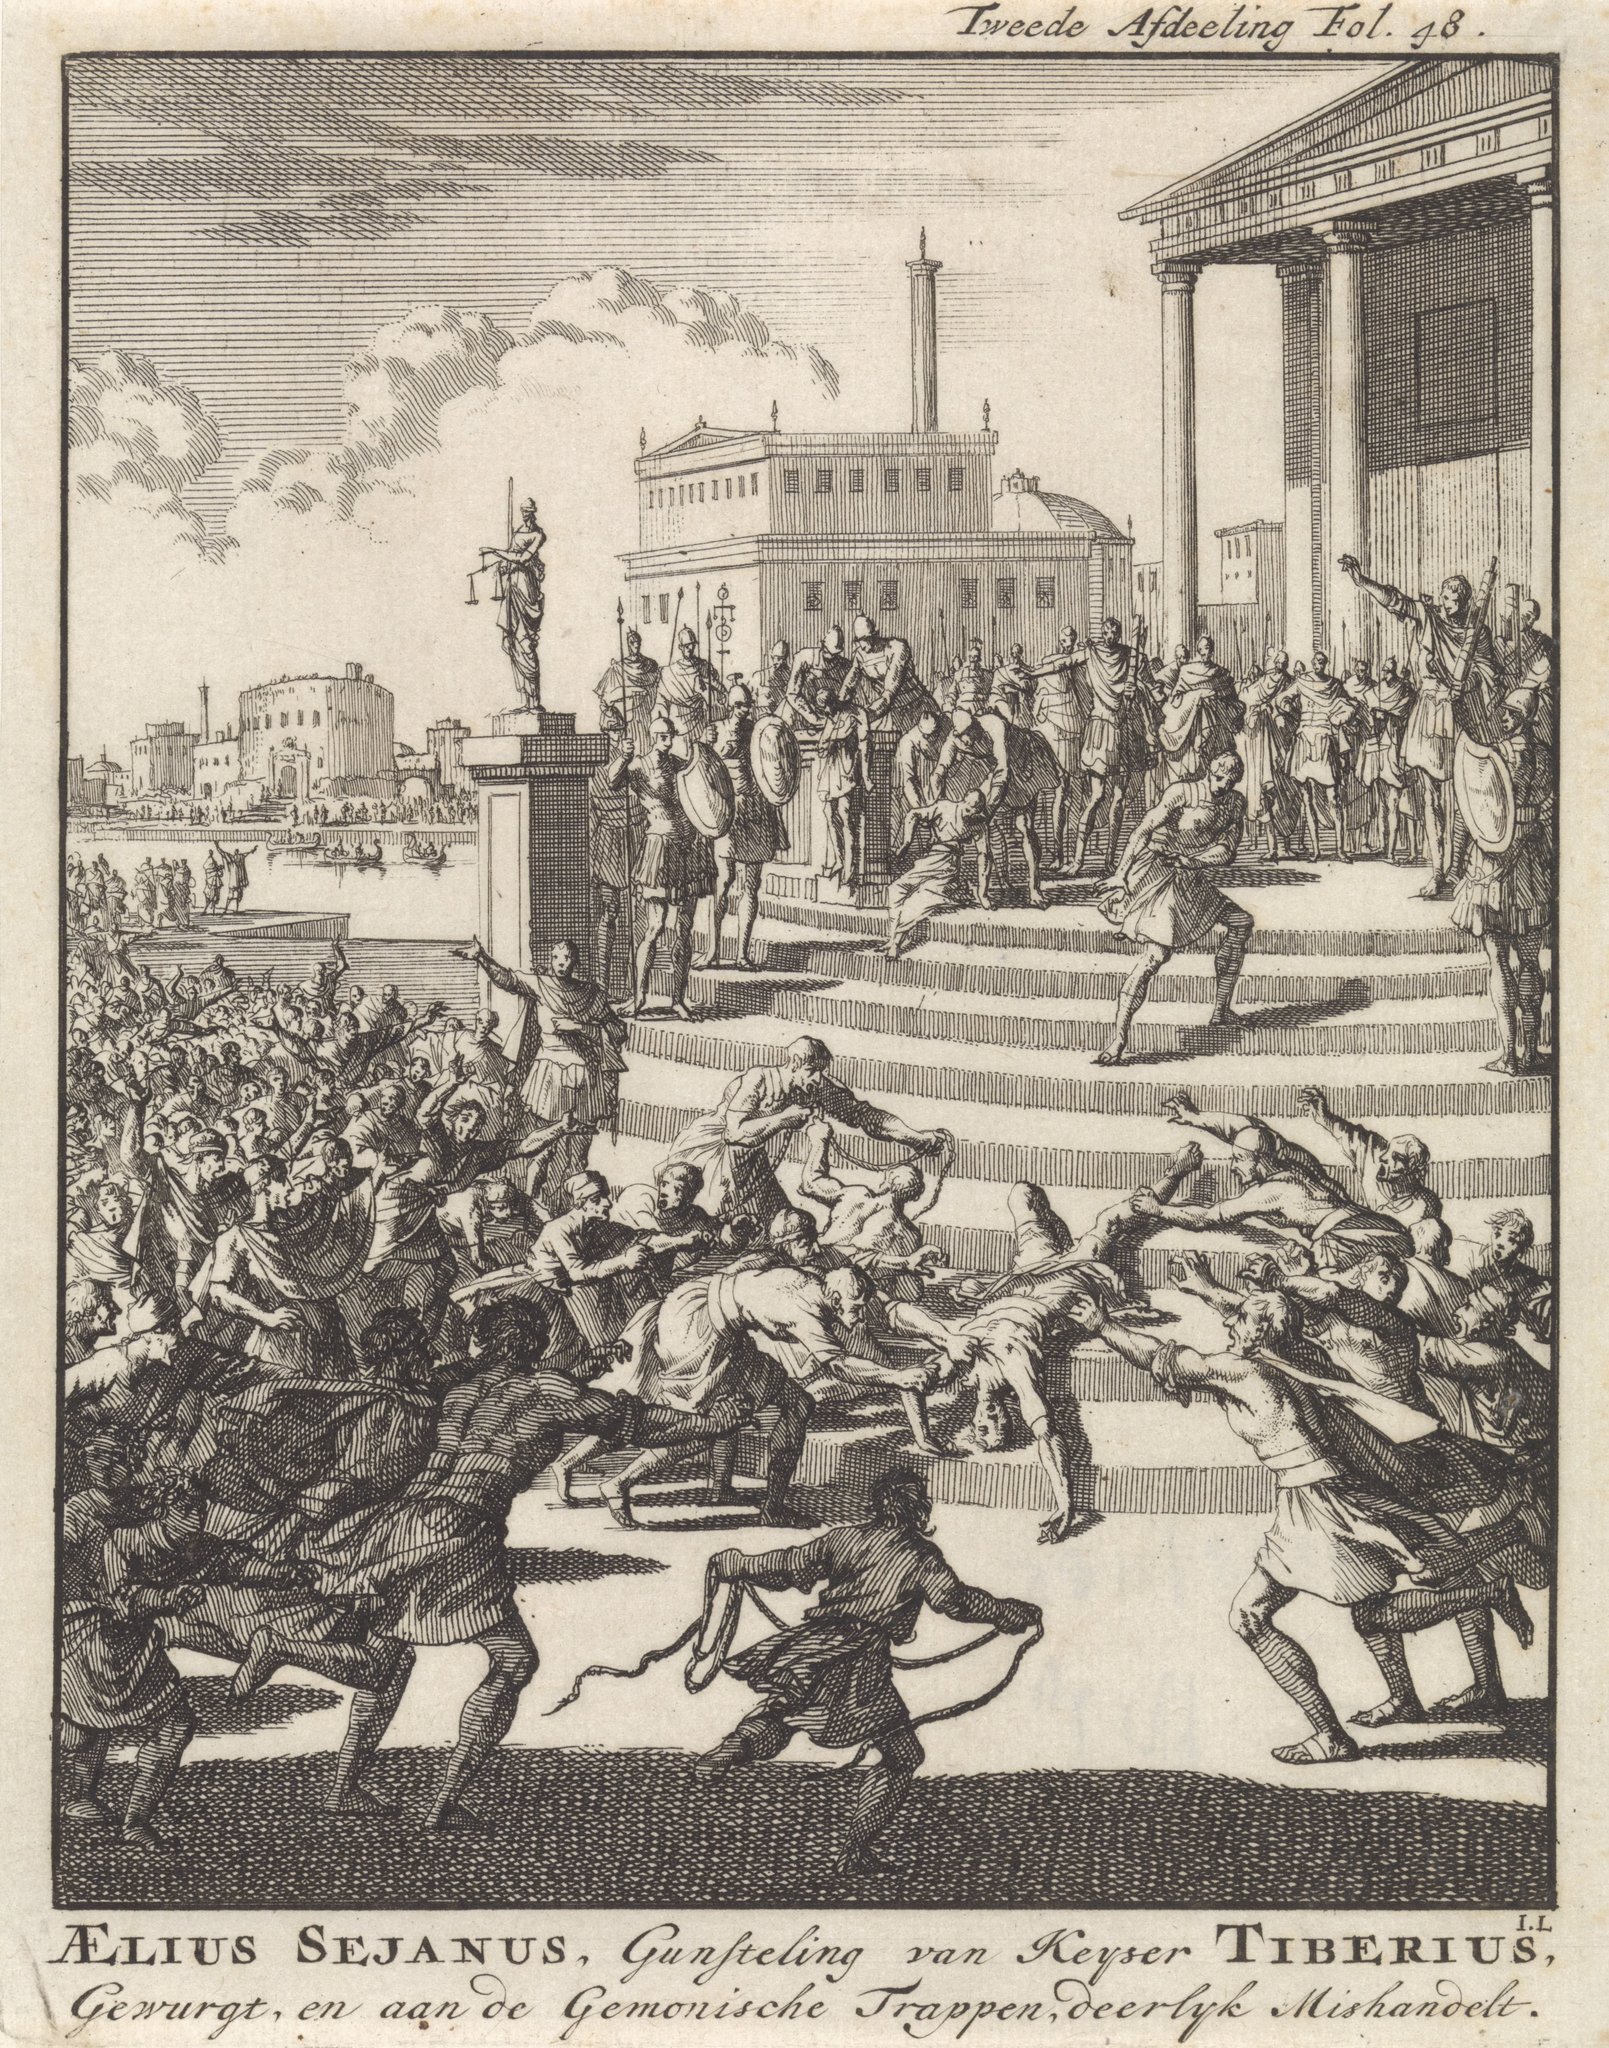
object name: print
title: Aelius Sejanus, Gunsteling van Keyser Tiberius, Gewurgt, en aan de Gemonische Trappen, deerlyk Mishandelt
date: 1698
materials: paper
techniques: etching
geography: amsterdam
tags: violent death, being killed; being mishandled and maltreated; seeking death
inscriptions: collector's mark: Lugt 2228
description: Illustratie uit: Bos, Lambert van den. Treur-toonneel der doorluchtige mannen, of Op- en ondergang der grooten, 3 delen. Amsterdam: Jan Claesz ten Hoorn, 1698, dl. I.